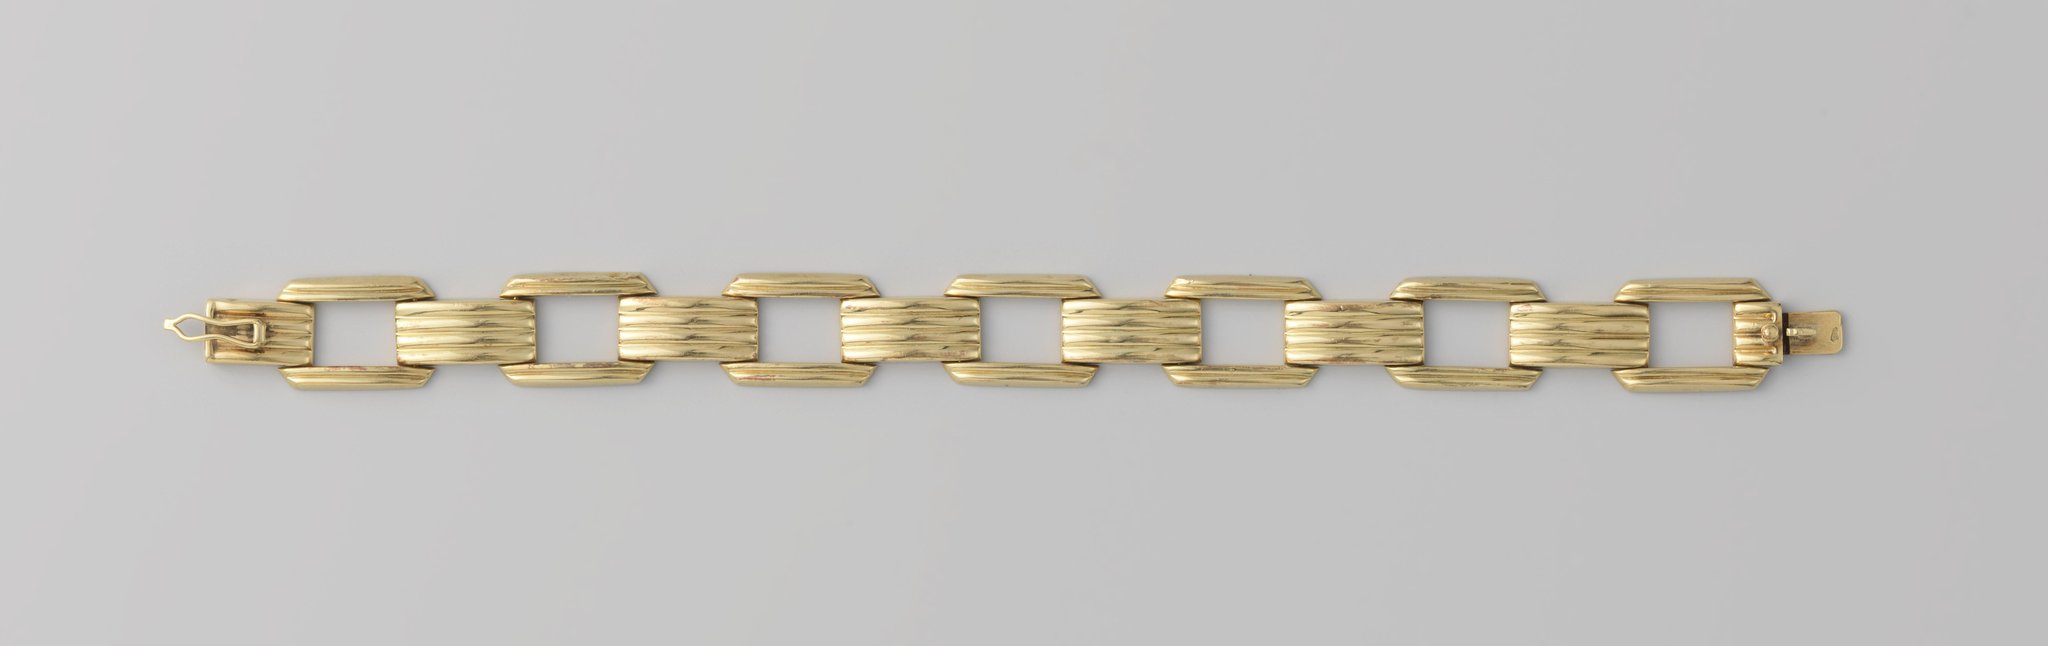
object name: chain bracelet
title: Gouden schakelarmband met geribde schakels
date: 1930-1950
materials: gold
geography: netherlands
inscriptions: alloy mark: ‘(oud) eikenblad’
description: Gouden schakelarmband met geribde schakels voorzien van een bakslot met een veiligheidsacht, geïmporteerd uit Duitsland, maar voorzien van het verantwoordelijkheidsteken van Begeer. Met een gewichtsaanduidend teken (3). Vermoedelijk is er een schakel uit de armband verwijderd, gezien het daadwerkelijke gewicht en het gewichtsaanduidend teken.